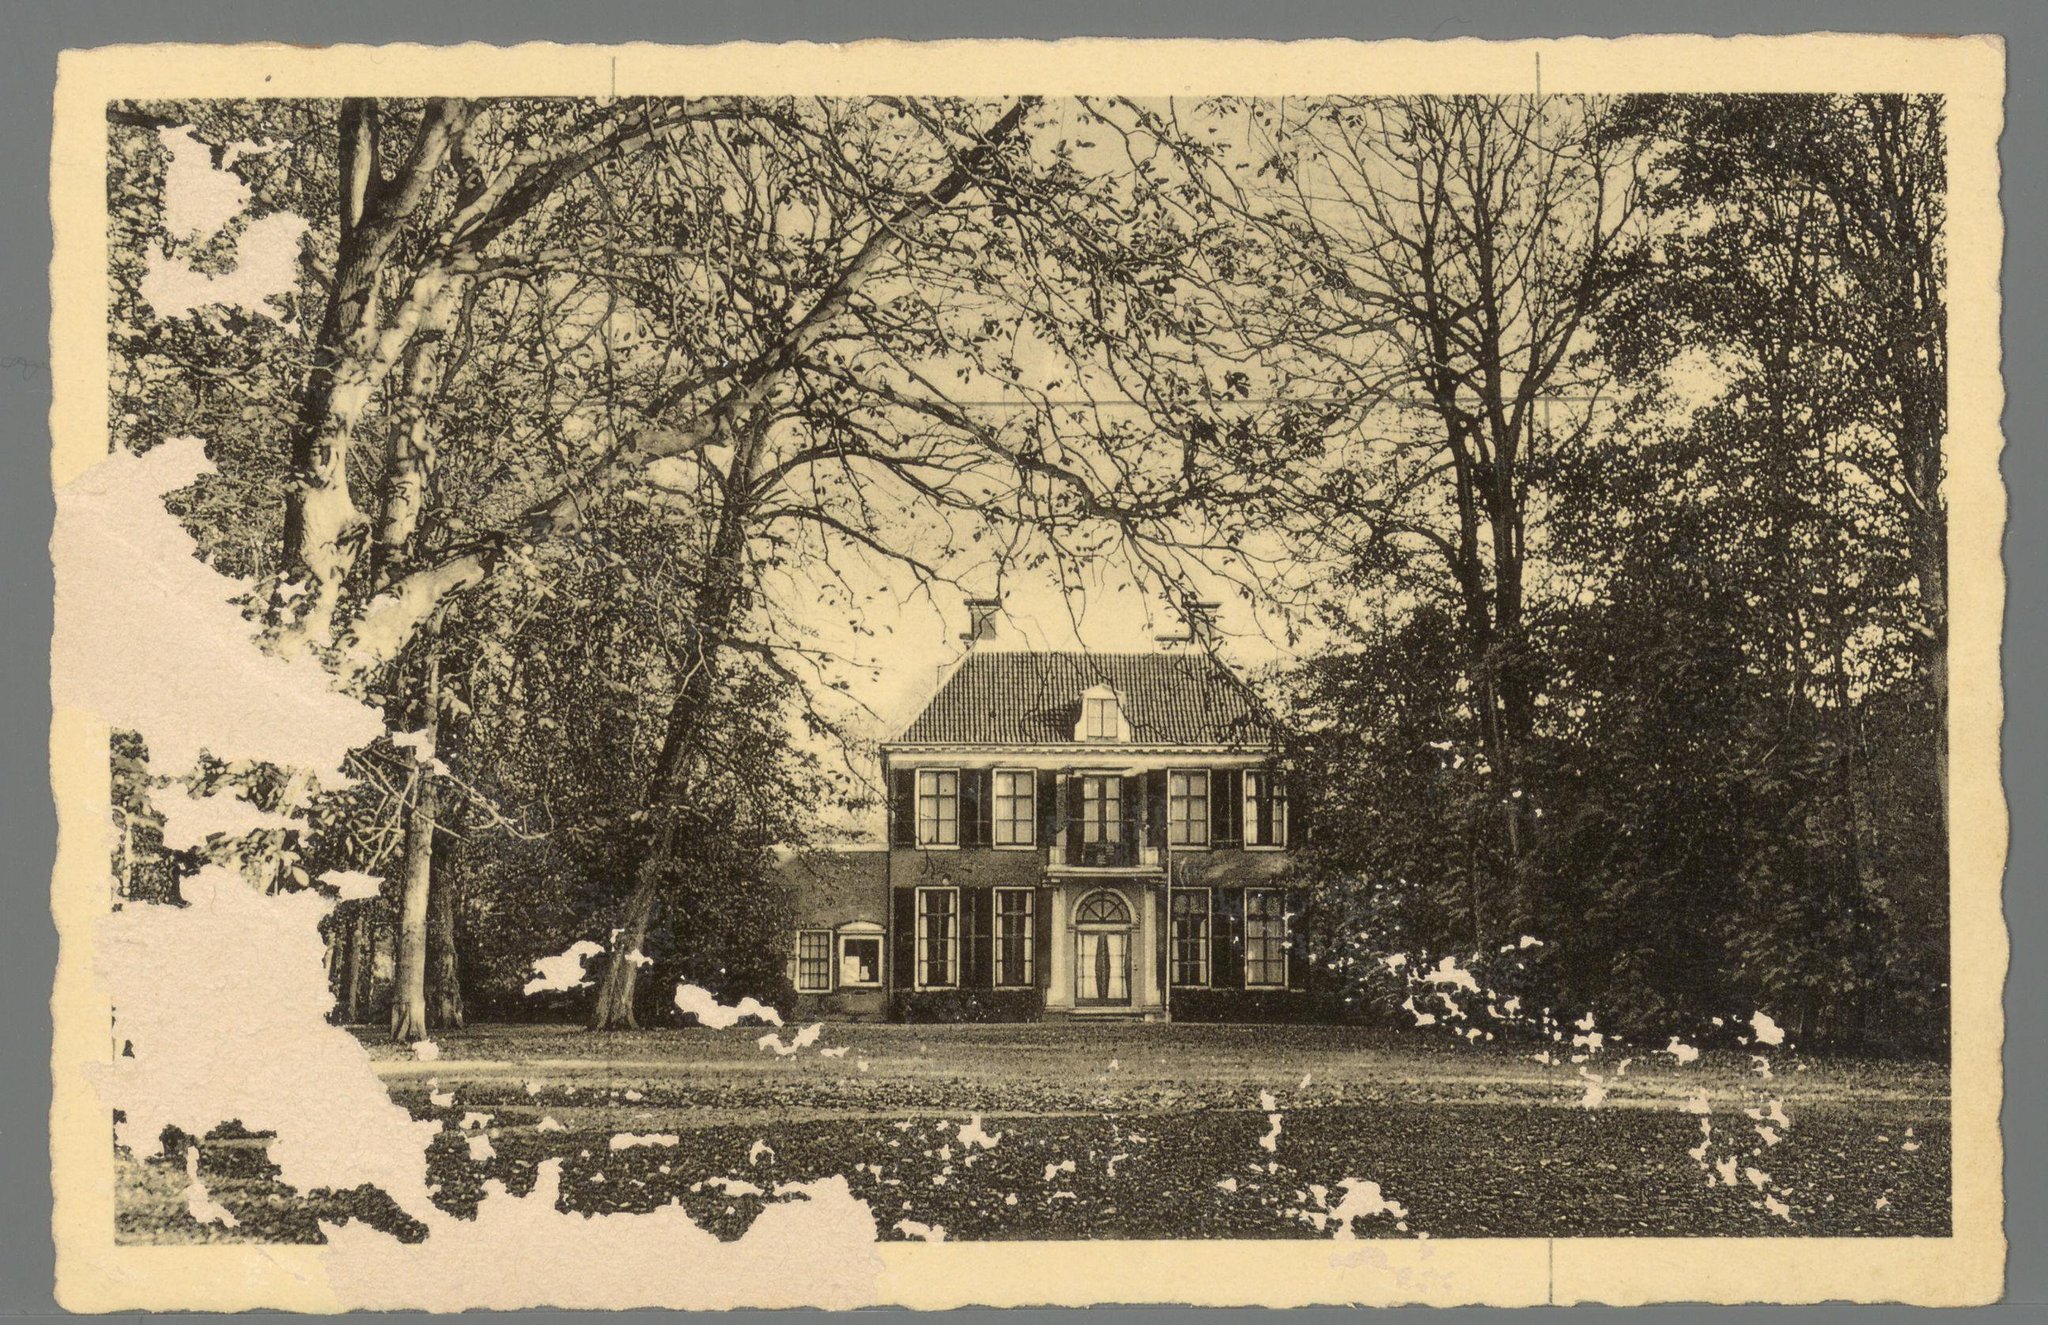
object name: ansichtkaart, prentbriefkaart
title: Breukelen. Gemeentehuis Boom en Bosch met park. Vroegere woning van Engel de Ruyter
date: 1913-1950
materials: cardboard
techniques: photograph, writing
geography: breukelen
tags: townhall, villa